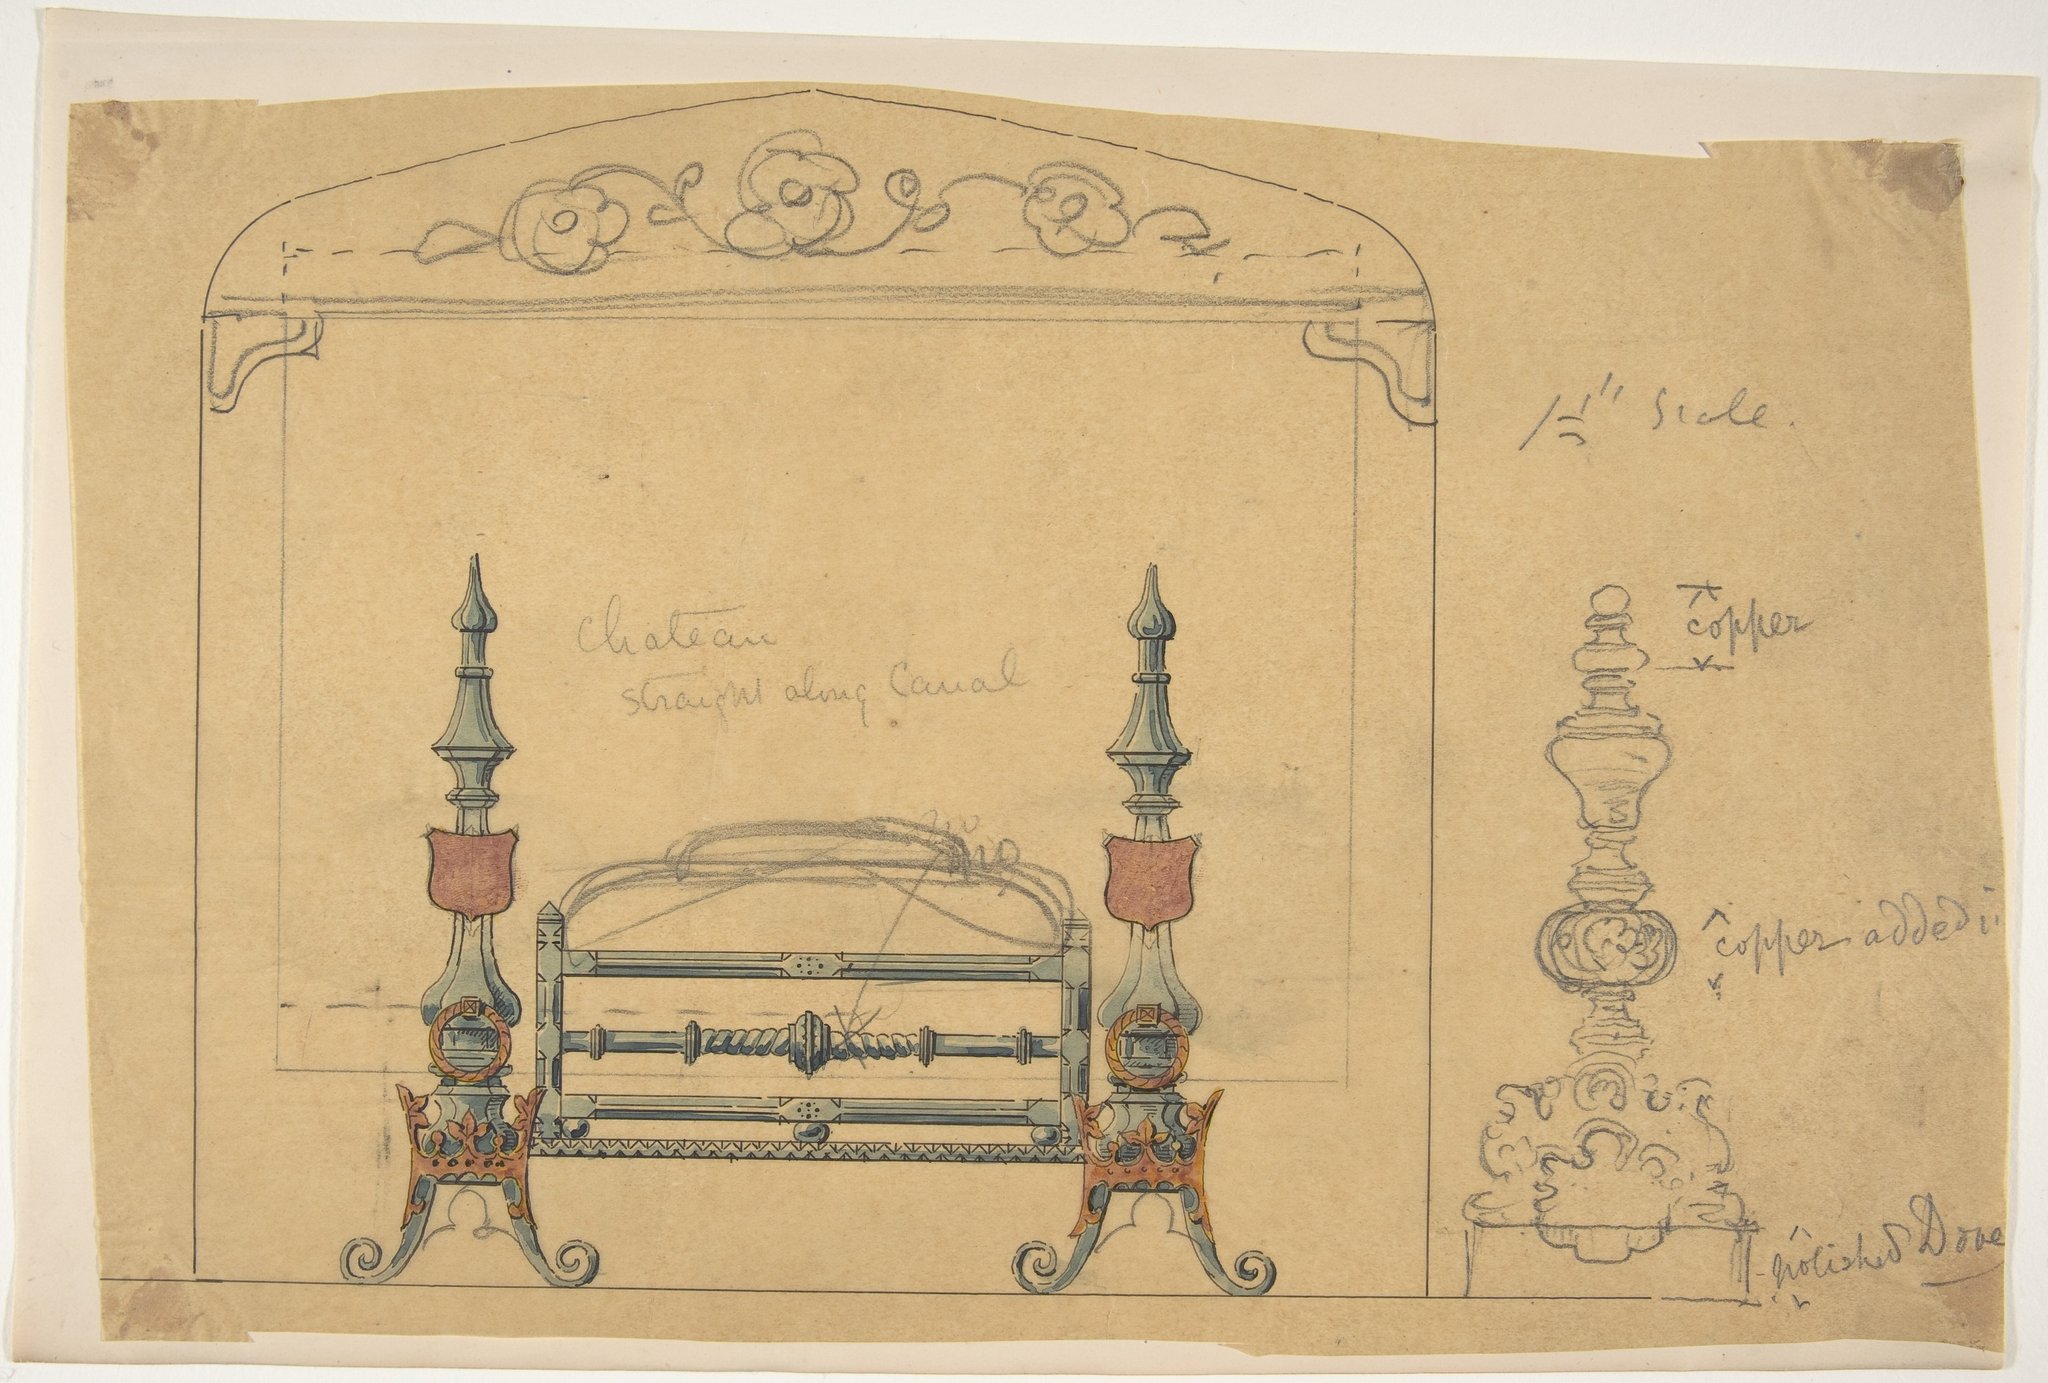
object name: drawing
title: Design for a Grate and Surrounding Mantel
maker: anonymous, british, 19th century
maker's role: artist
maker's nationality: british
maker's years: 1800-1900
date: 1801-1900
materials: graphite, ink, watercolor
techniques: pen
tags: fireplaces